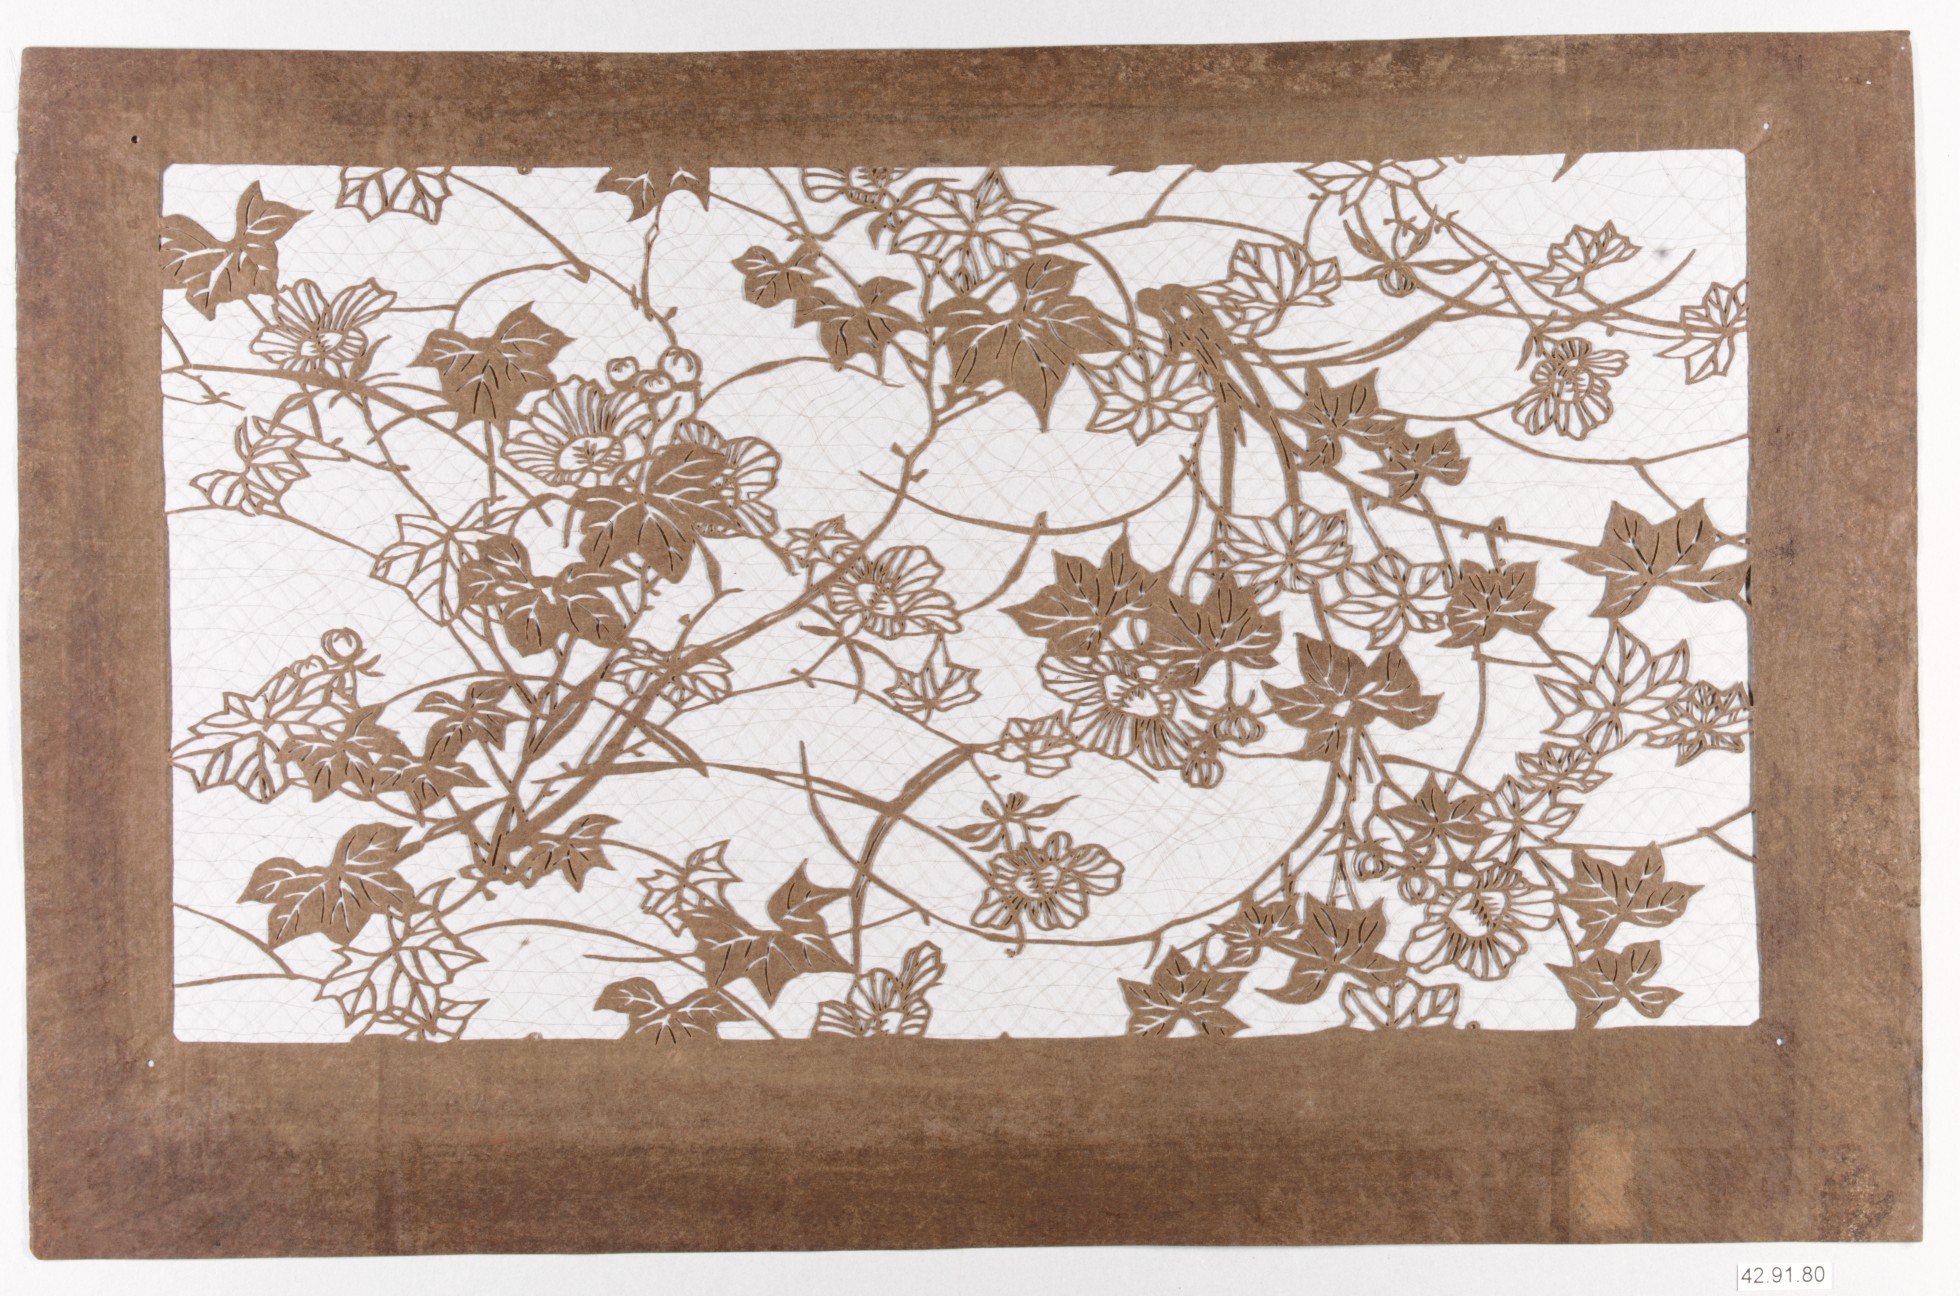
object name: stencil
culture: japanese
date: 1801-1900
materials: paper, silk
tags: flowers